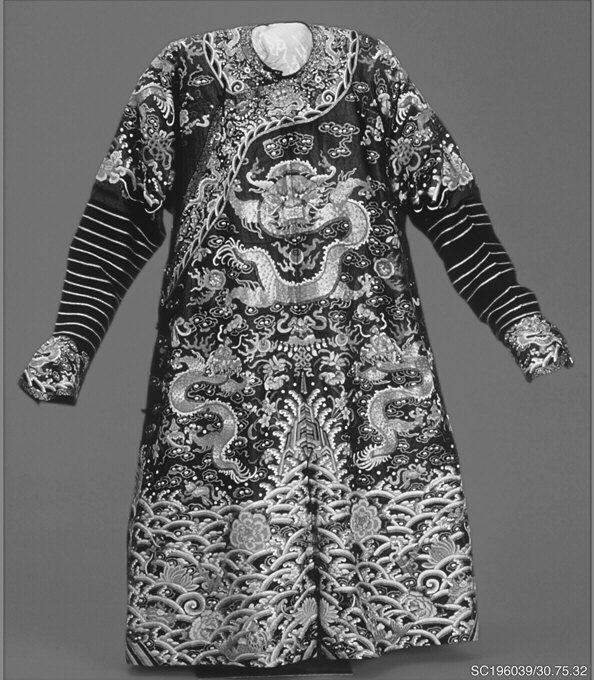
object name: robe, imperial court, summer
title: Summer Imperial Court Robe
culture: chinese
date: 1736-1795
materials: metal thread, silk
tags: dragons